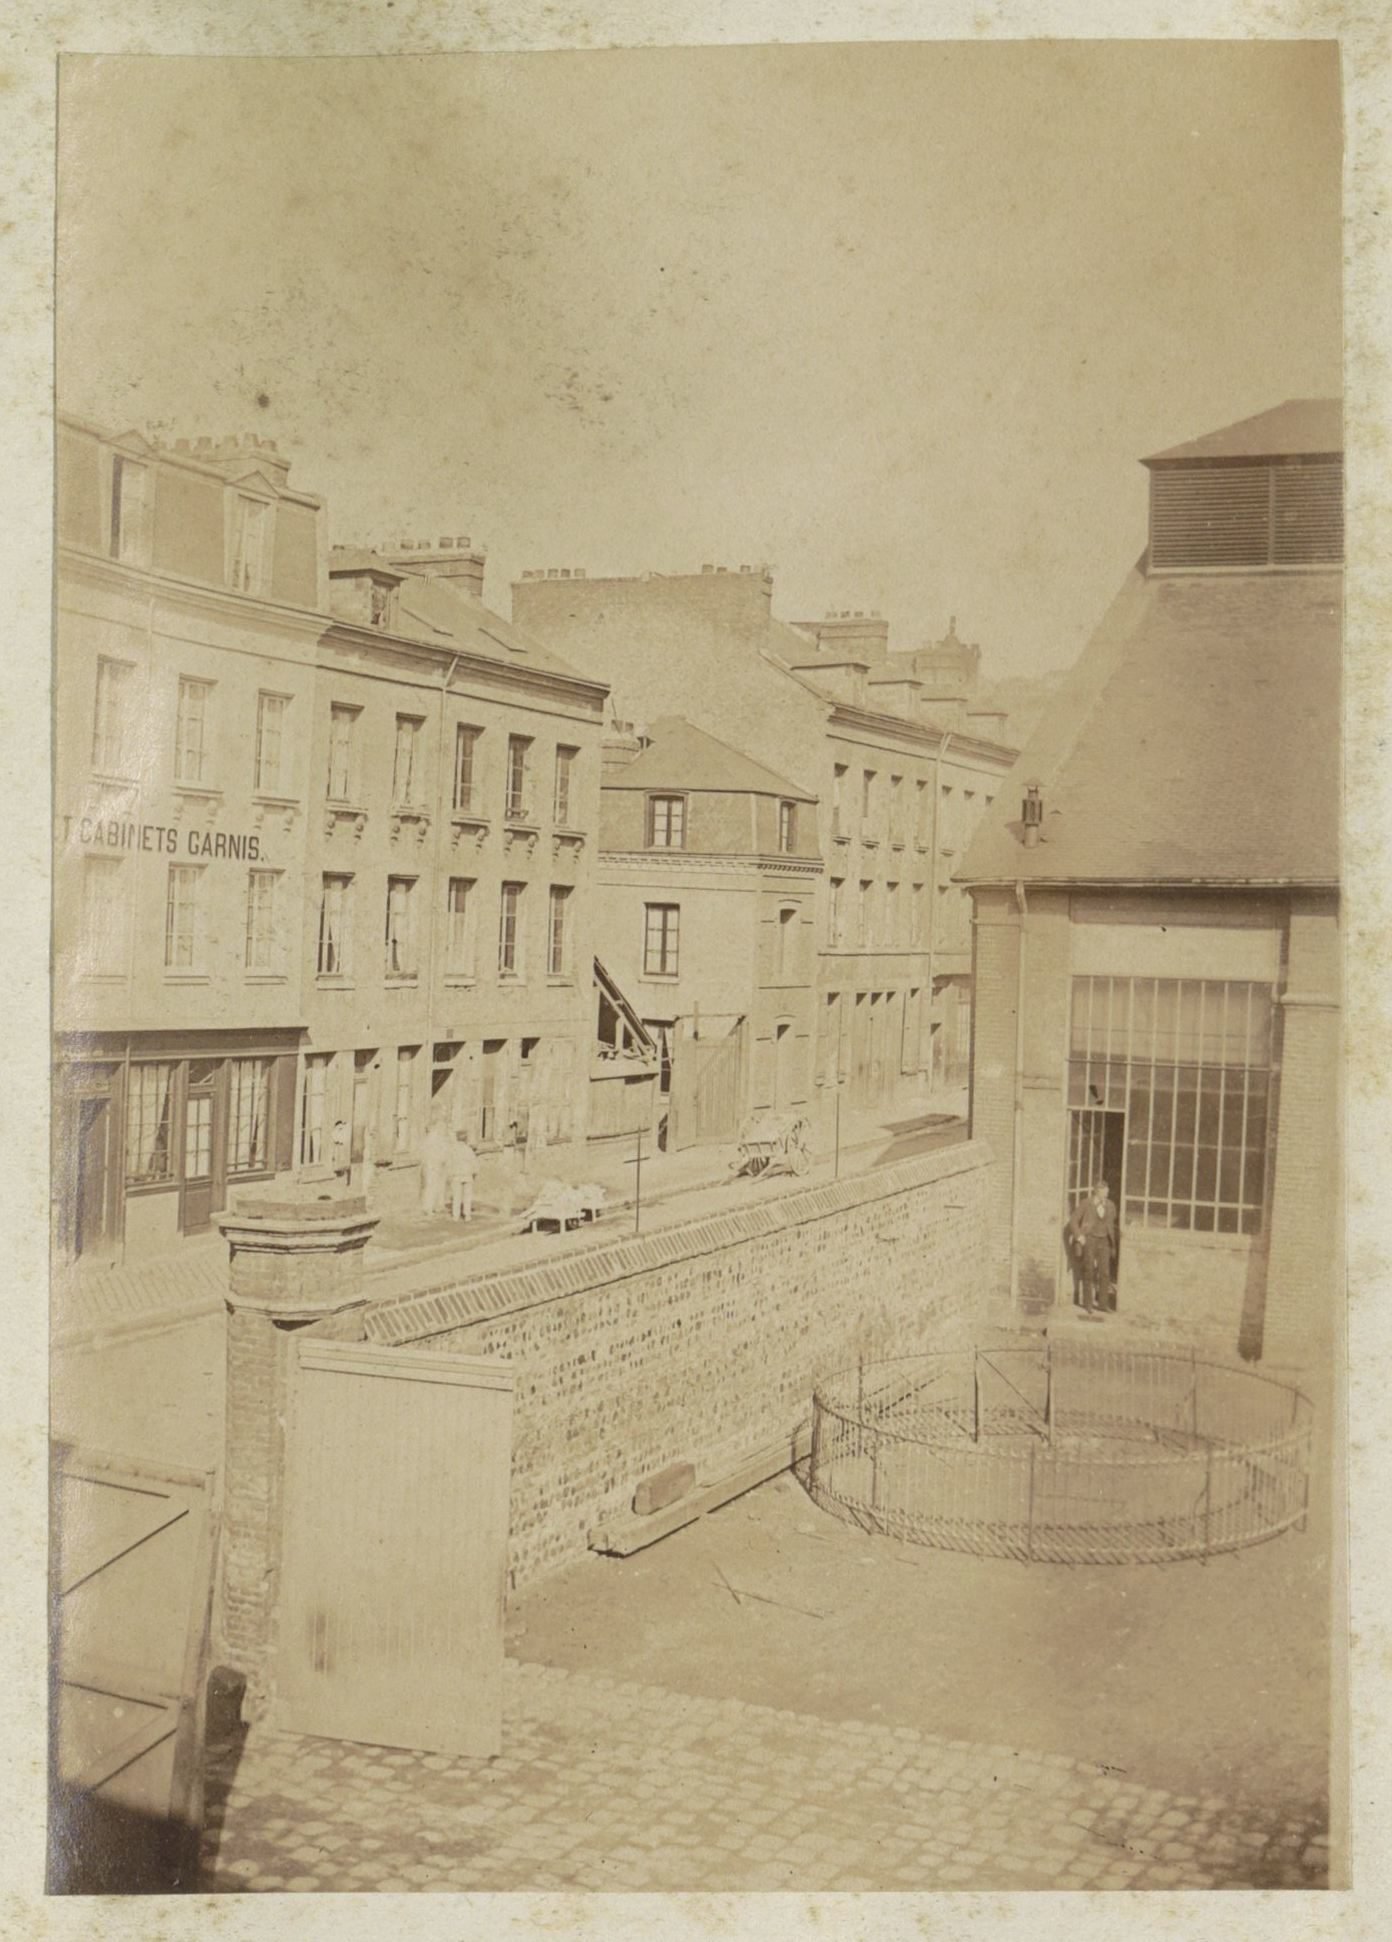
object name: photograph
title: Straatgezicht in Frankrijk met meubelmakerij en schoolplein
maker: Anonymous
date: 1883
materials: photographic support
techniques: albumen print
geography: france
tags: joiner, cabinet maker, 'ébéniste', teacher and pupil (+ teacher, professor), elementary school; class, form, street (+ city(-scape) with figures, staffage), france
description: Onderdeel van Album van een Franse amateurfotograaf met opnames van familie, militairen, industrie, landschappen en bezienswaardigheden in Frankrijk.